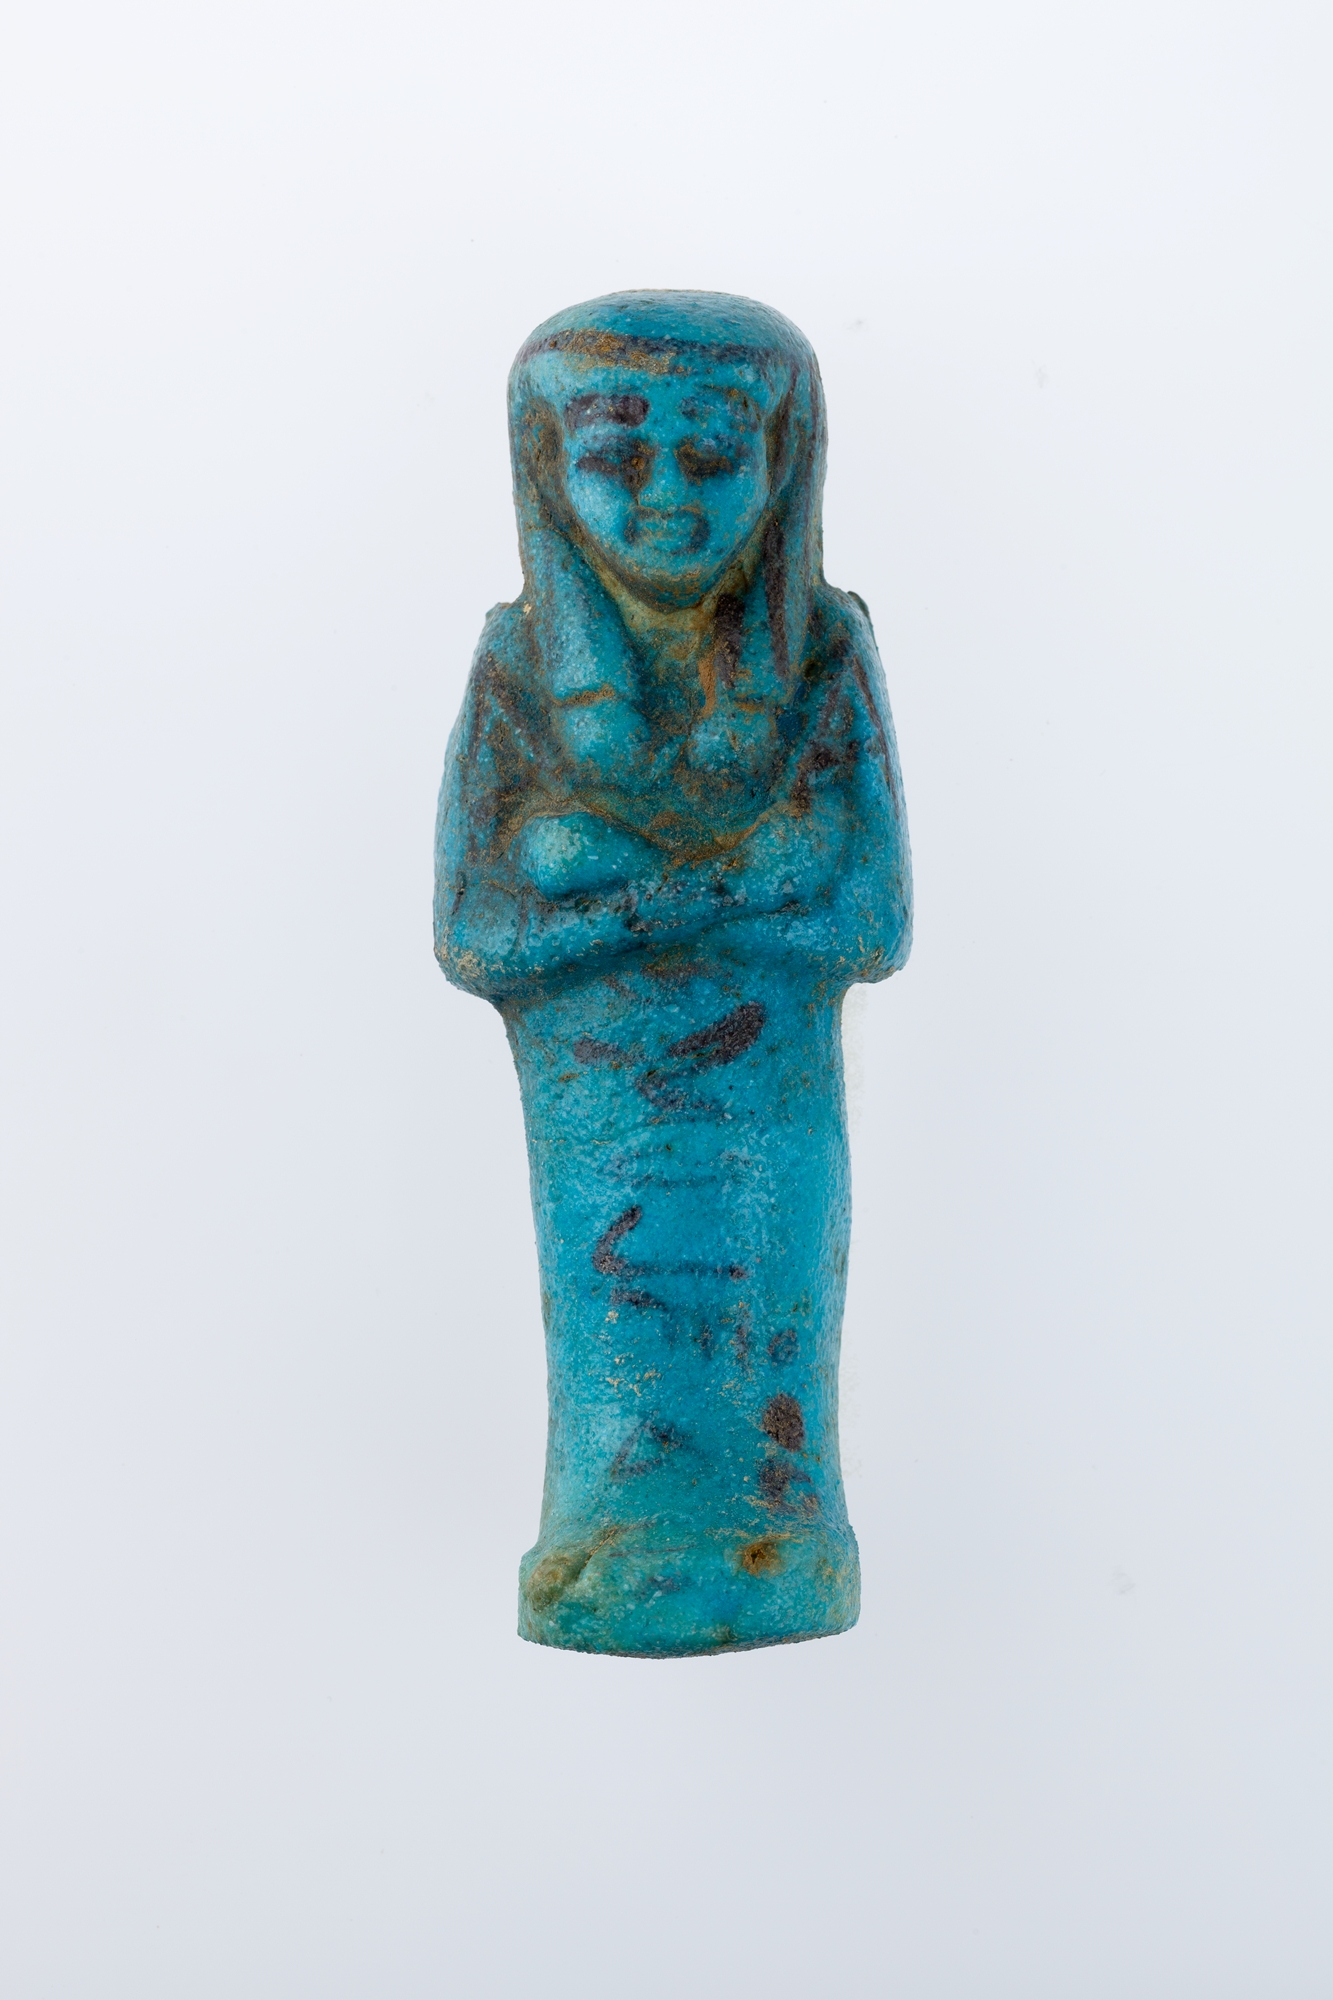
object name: shabti, henettawy c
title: Worker Shabti of Henettawy (C), Daughter of Isetemkheb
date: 990-970 BCE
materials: faience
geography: egypt